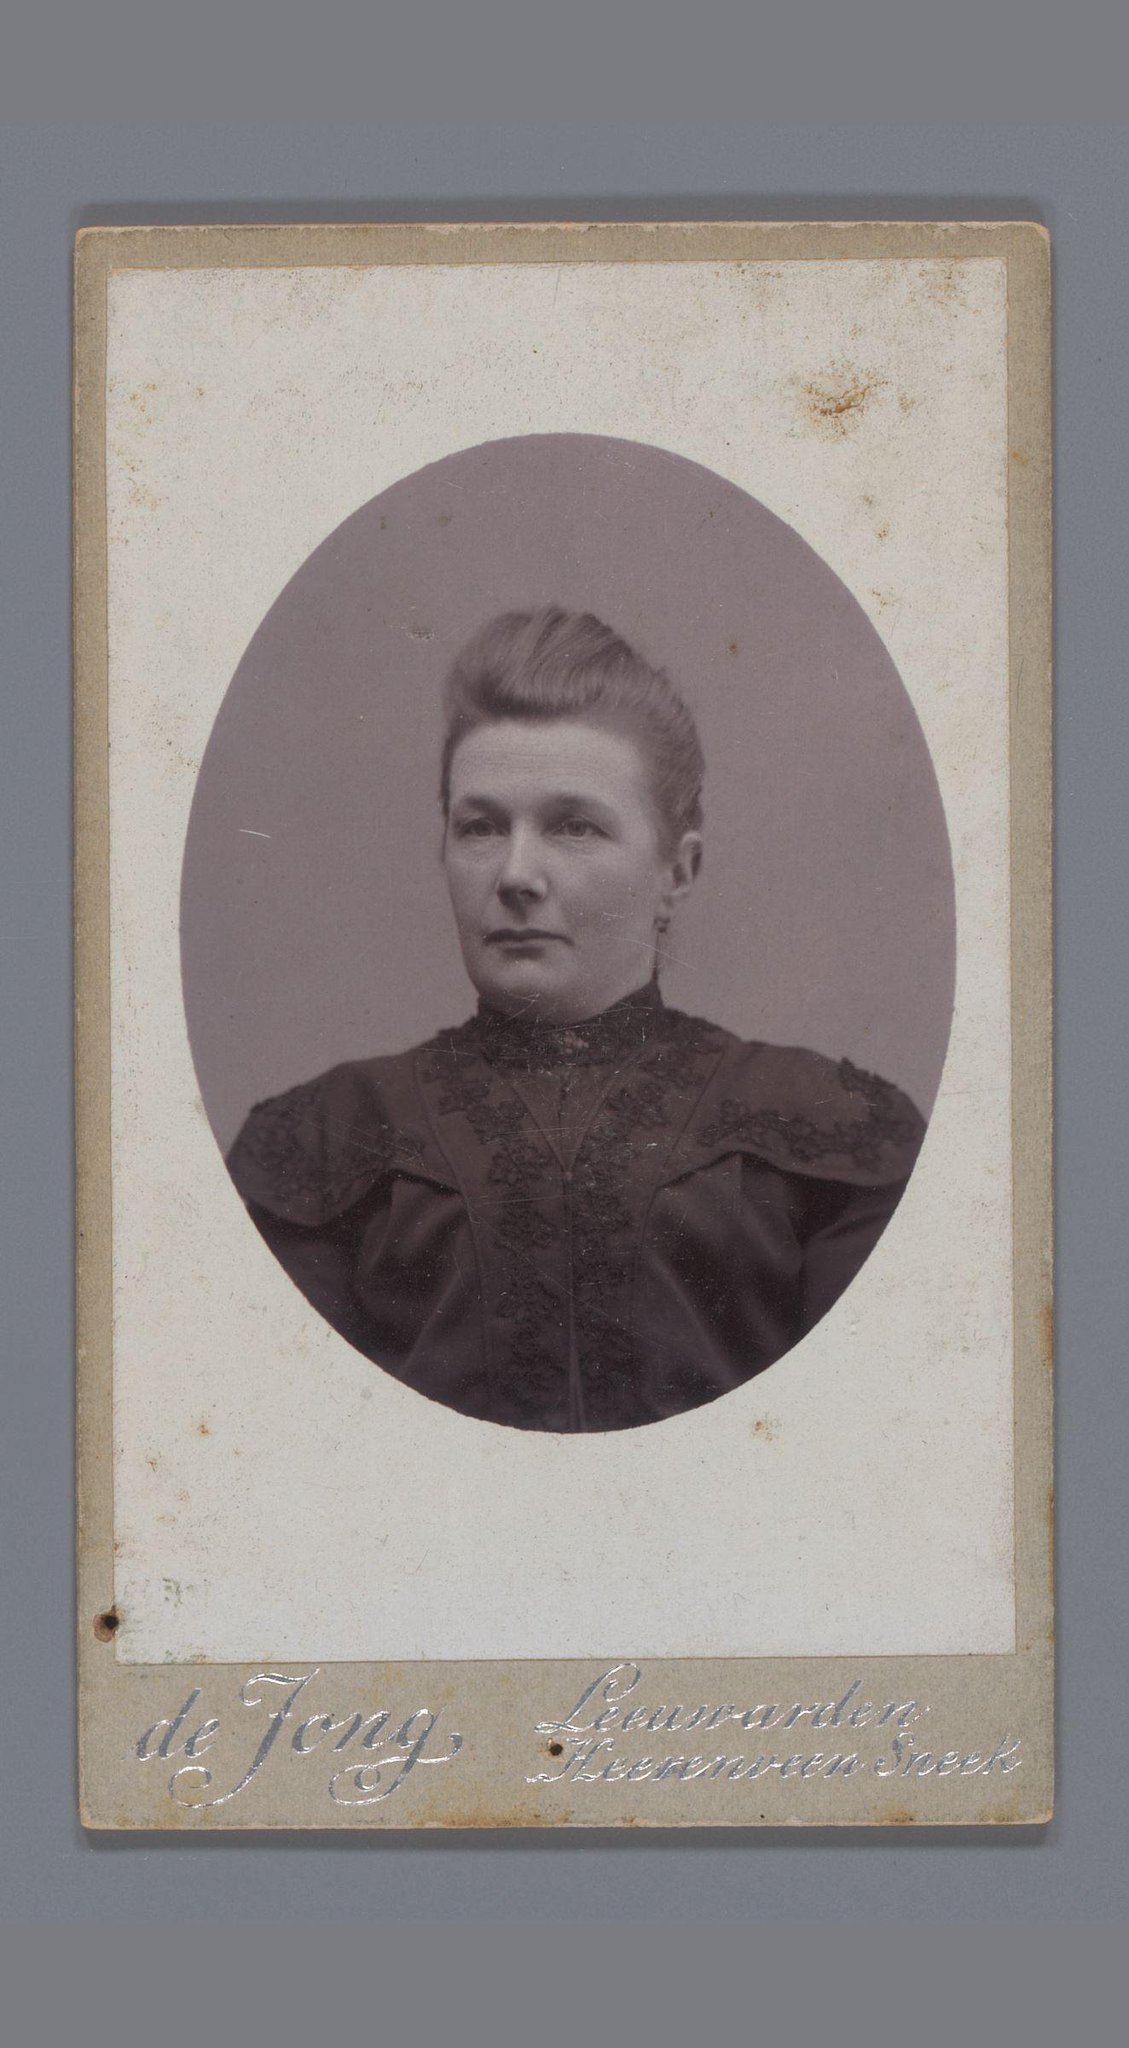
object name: carte de visite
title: Portret van Trijntje Schaver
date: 1907-1910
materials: cardboard, photographic support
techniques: collodion silver print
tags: historical persons - bb - woman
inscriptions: inscription: ‘Trijntje/ Schaver/ get. met Klaas Okkinga’, inscription: ‘Fotogr./ Atelier/ de Jong/ Nieuwestad 53./ LEEUWARDEN/ HEERENVEEN/ SNEEK/ Vergrootingen naar elk Portret/ DE PLAAT BLIJFT VOOR NABESTELLING BEWAARD/ 1907.’